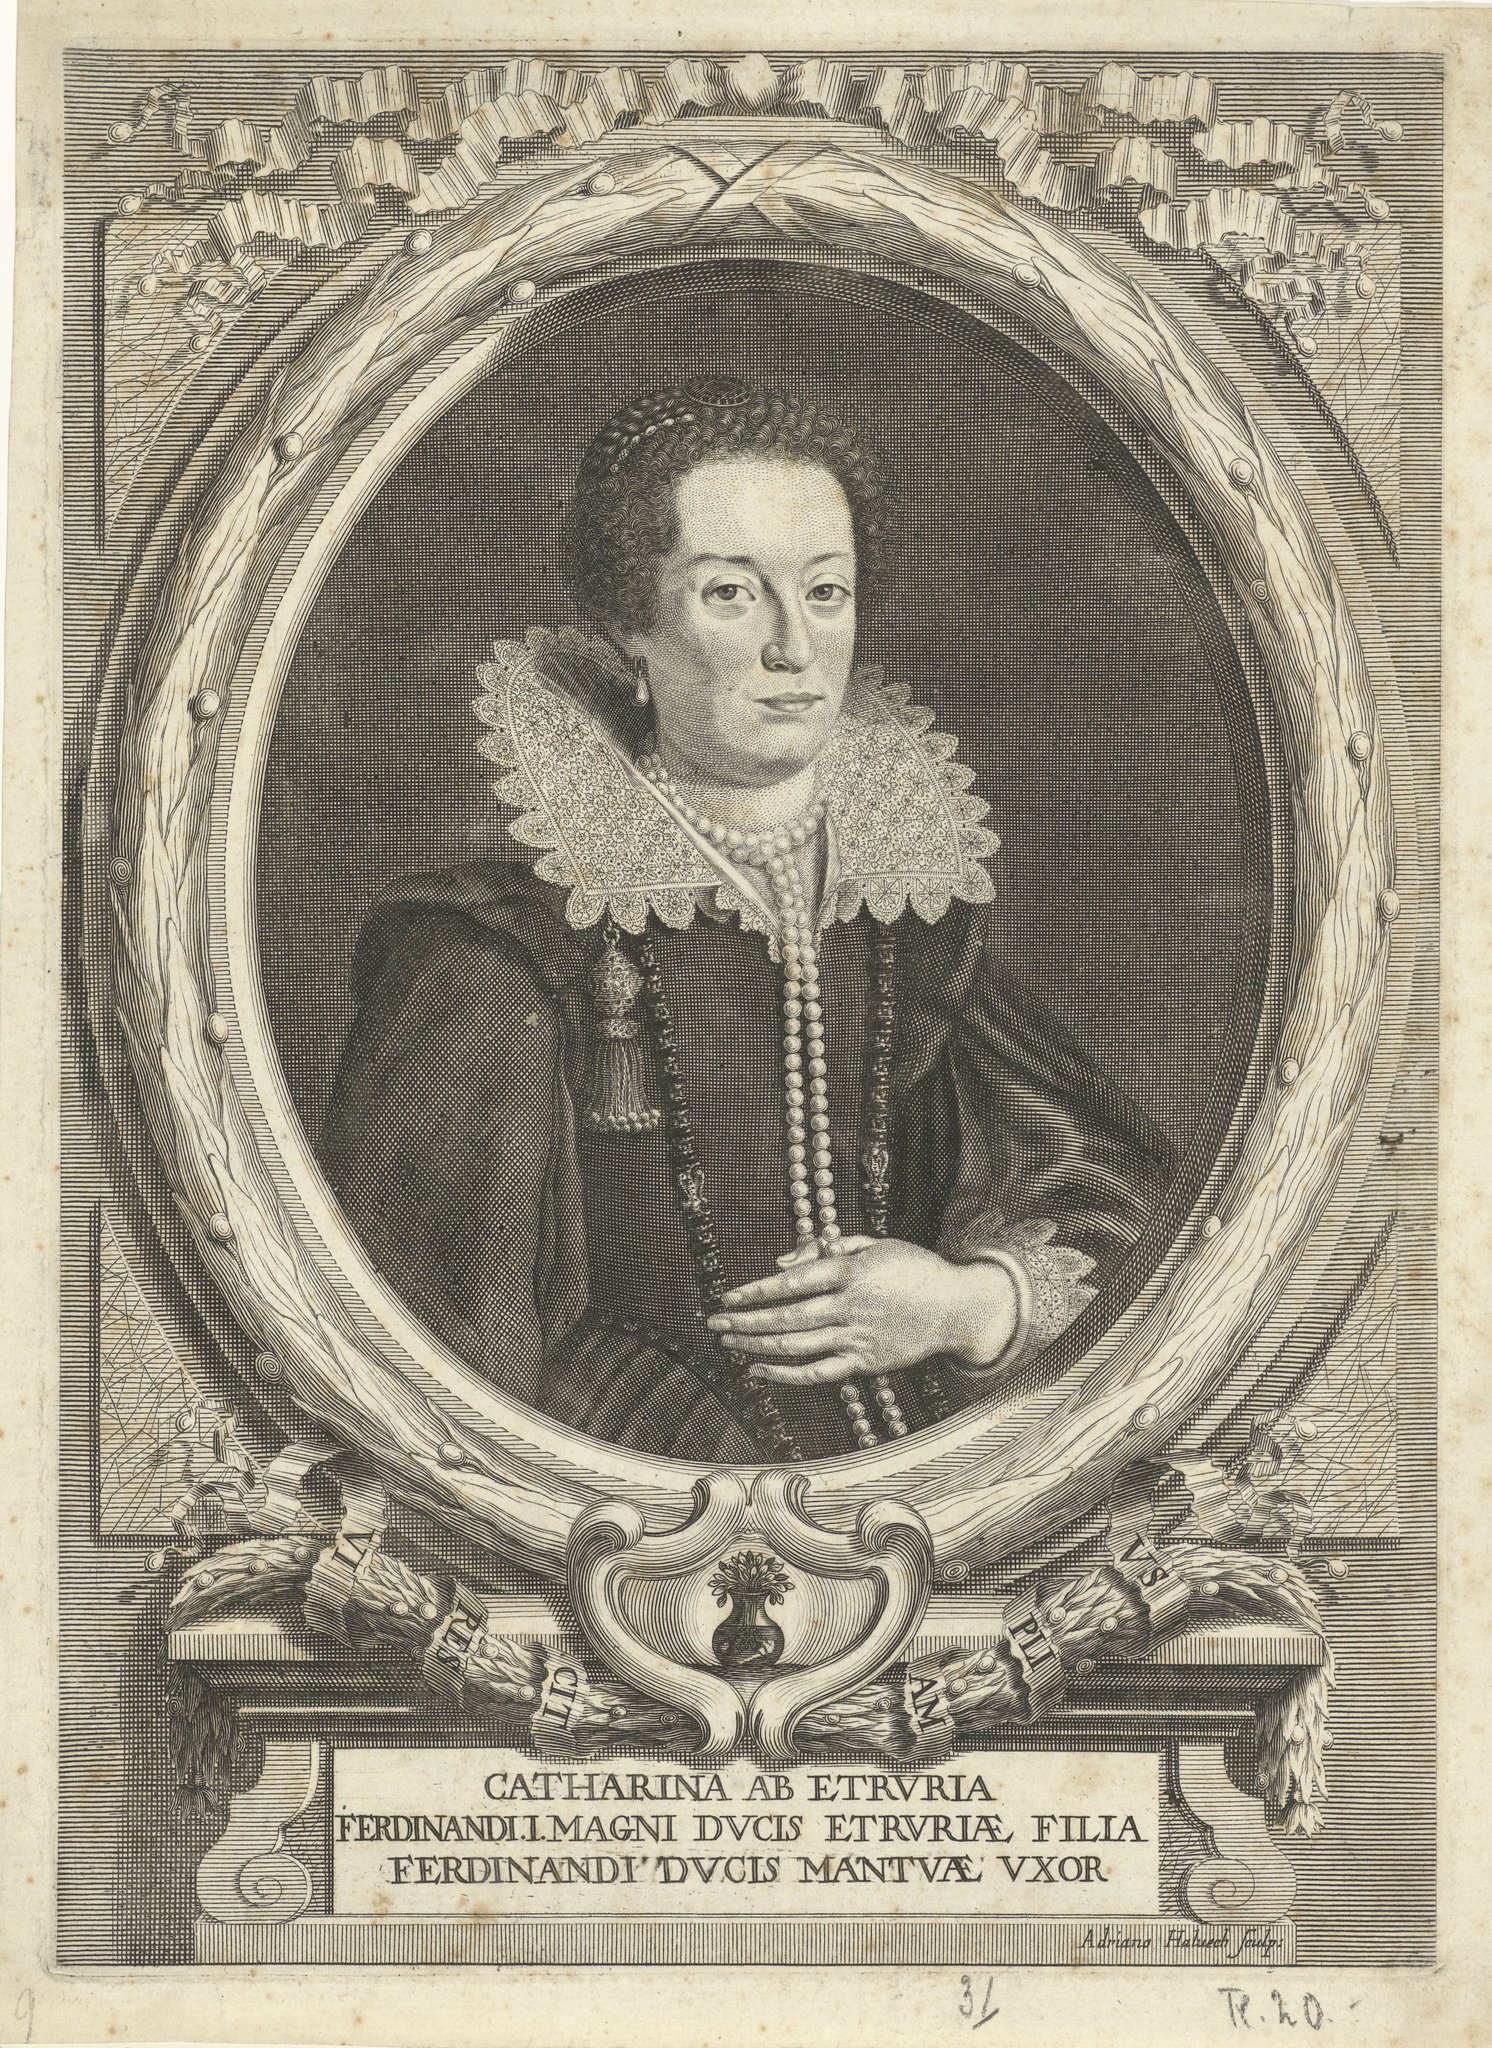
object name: print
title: Portret van Catharina de Medici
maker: adriaen haelwegh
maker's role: print maker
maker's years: 1637-1702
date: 1660-1696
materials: paper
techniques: engraving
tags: styles of hairdress - aa - ~ women, neck-gear ~ clothing (+ women's clothes), pearl; pearl necklace (+ women's clothes)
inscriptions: collector's mark: Lugt 2228, collector's mark: Lugt 2760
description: Portret ten halven lijve van Catharina de Medici, in een ovaal omringd met een lauwerkrans.